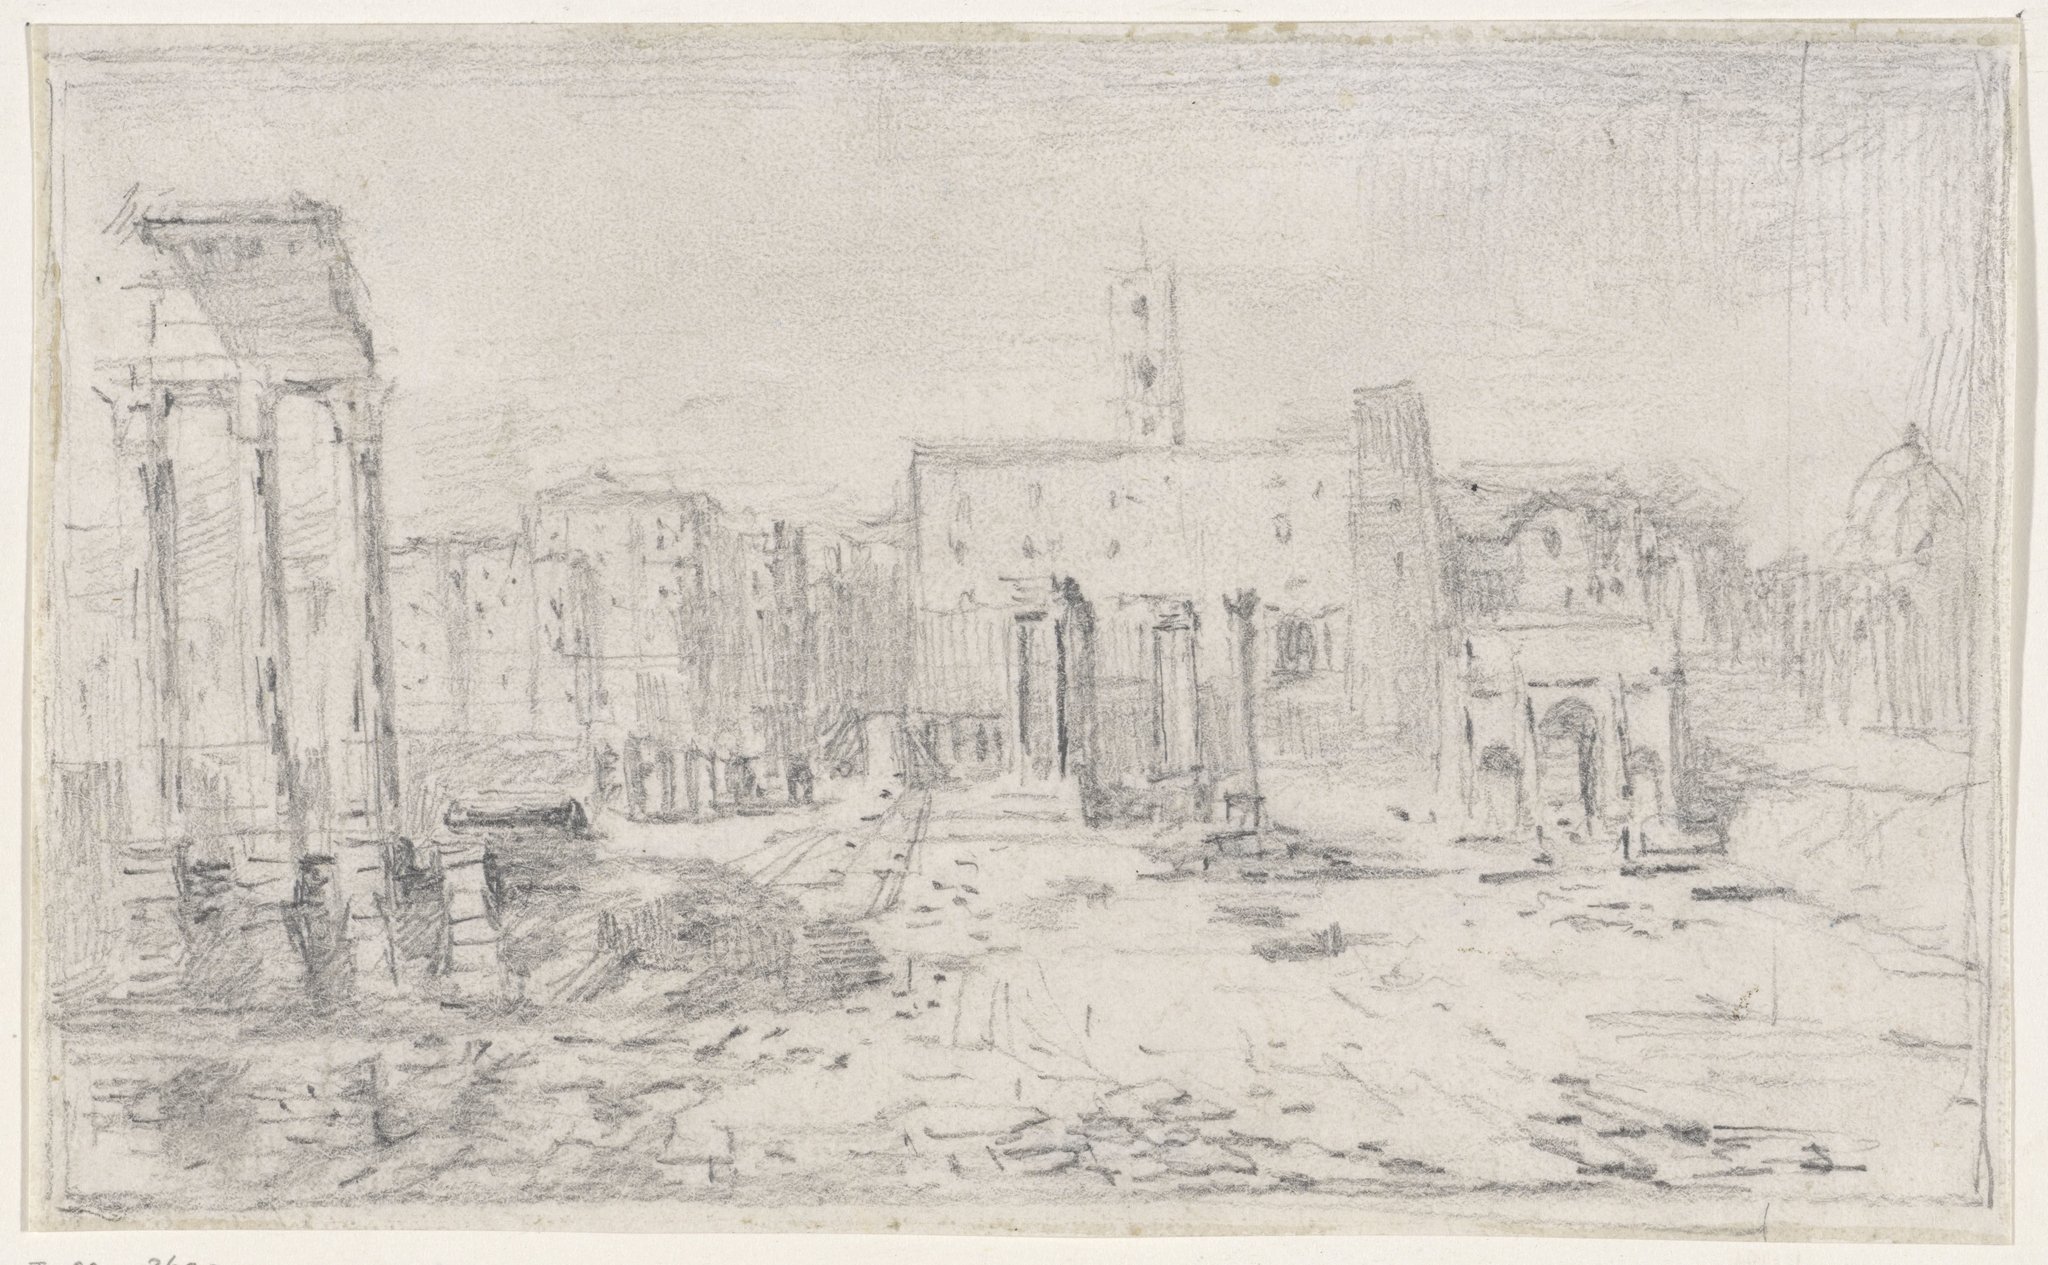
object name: drawing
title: Gezicht op het Forum Romanum en de Campidoglio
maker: thomas cool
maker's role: draughtsman, painter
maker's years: 1851-1904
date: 1861-1904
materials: paper, pencil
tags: landscape with ruins, rome